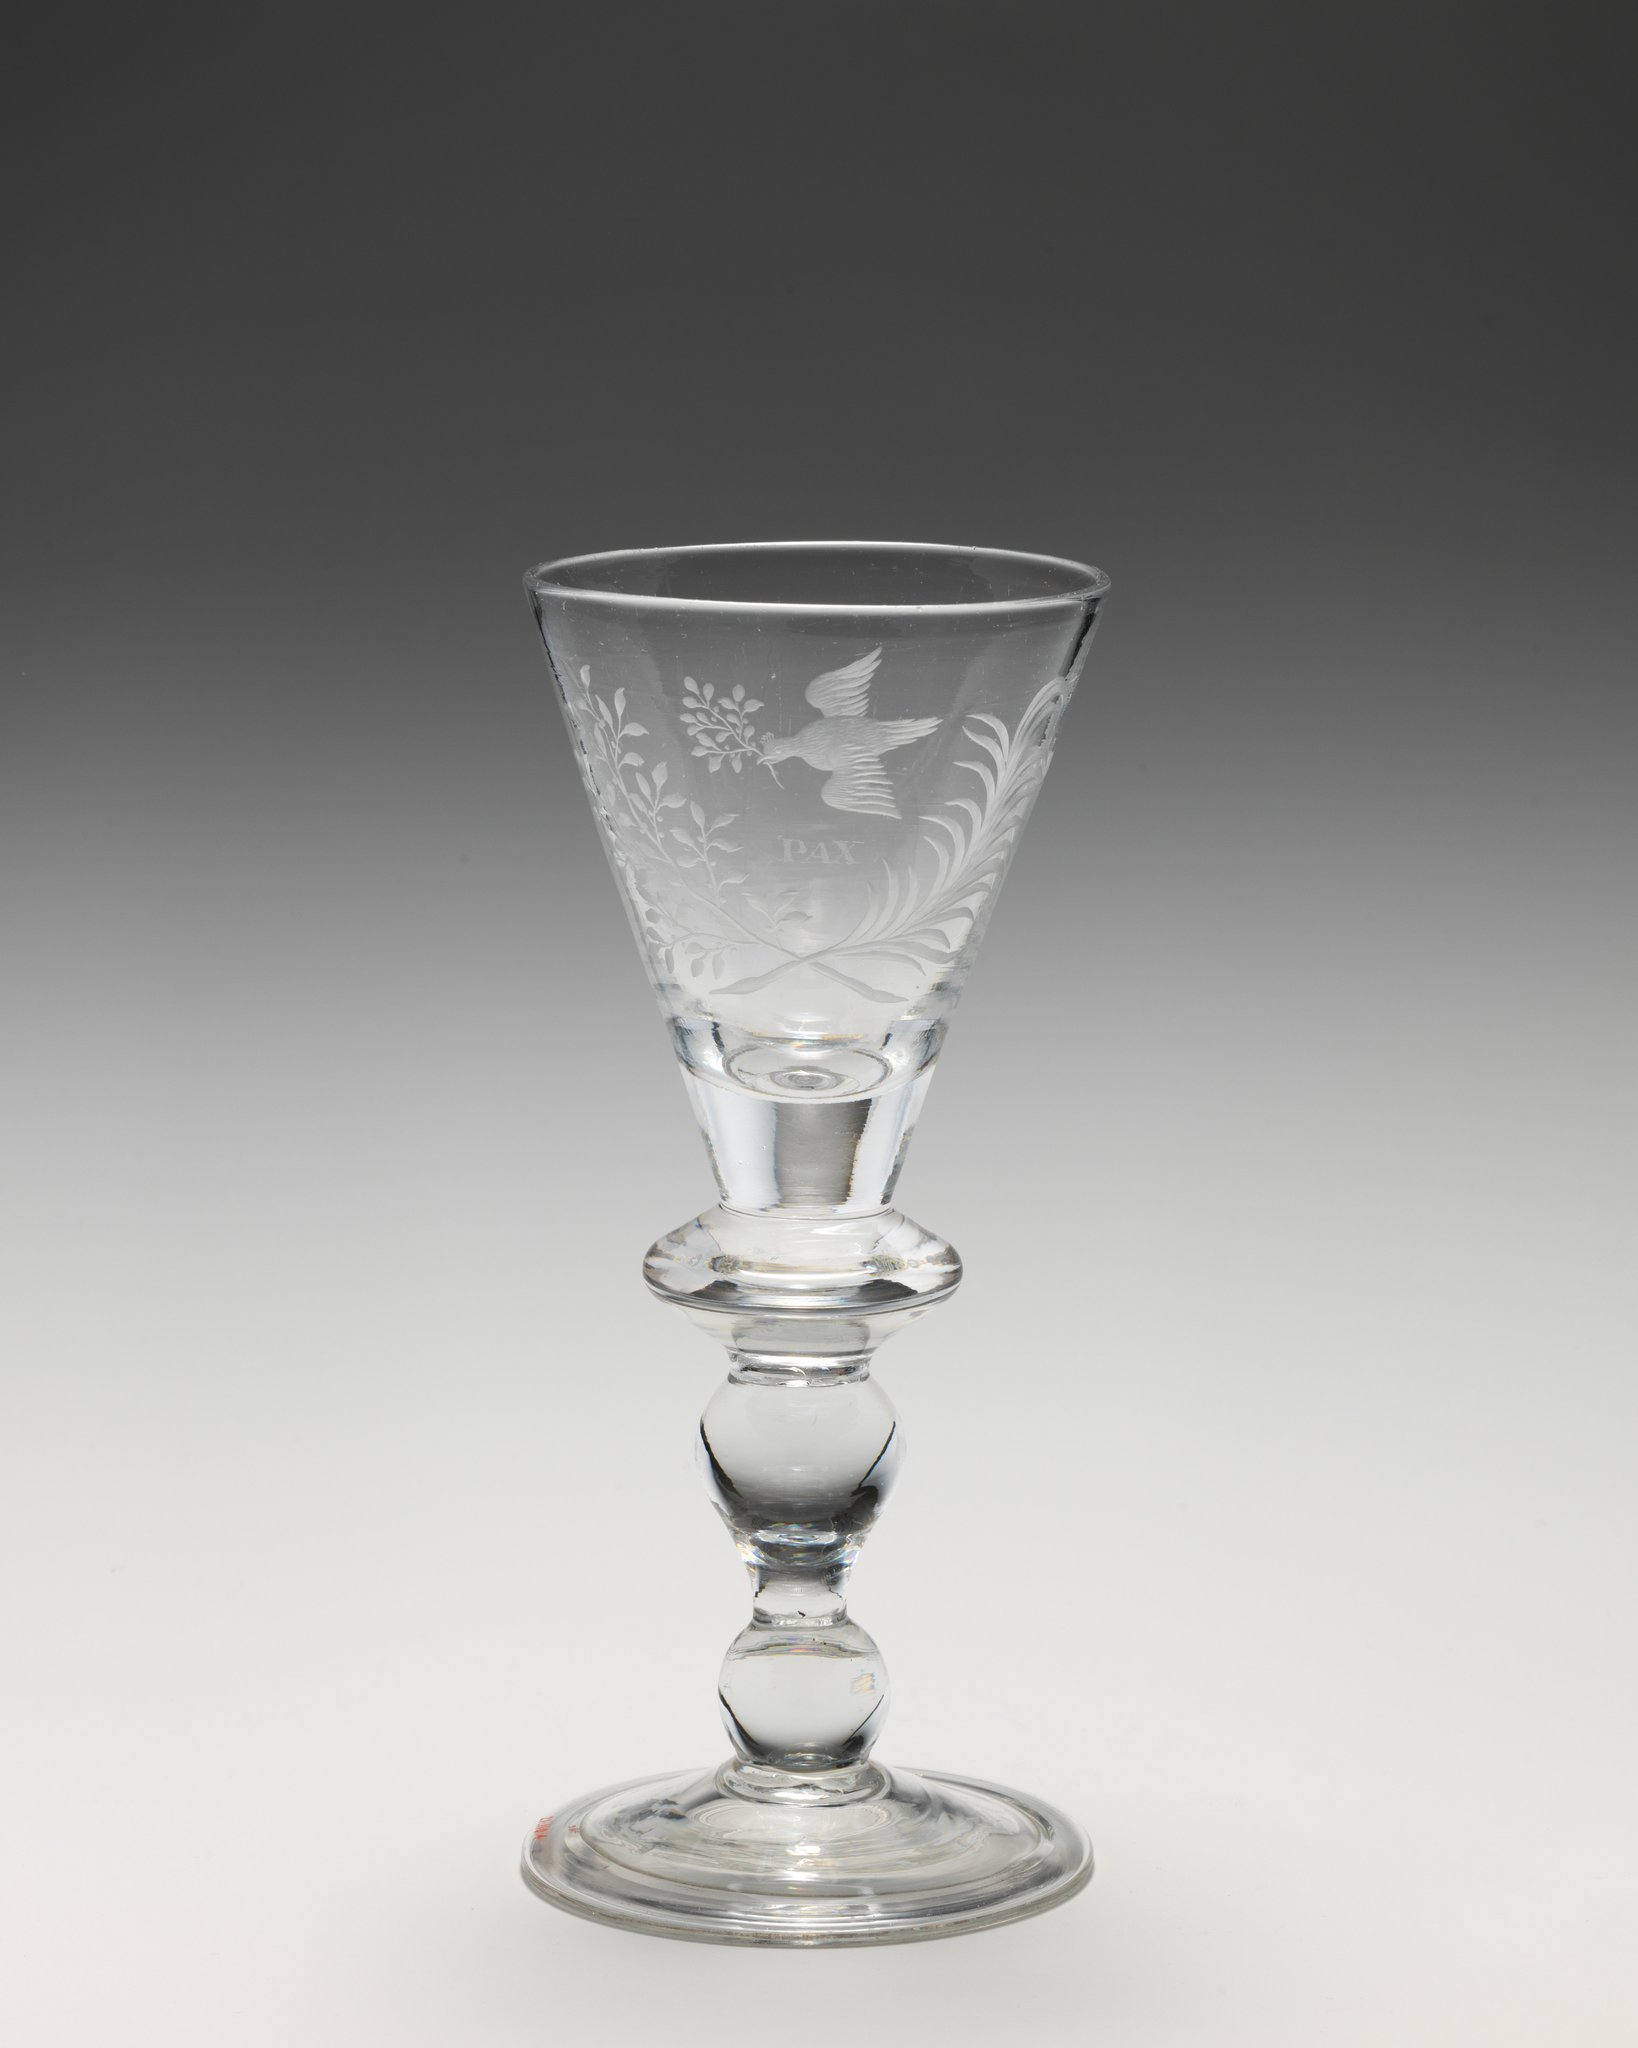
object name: wineglass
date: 1700-1750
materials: glass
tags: birds